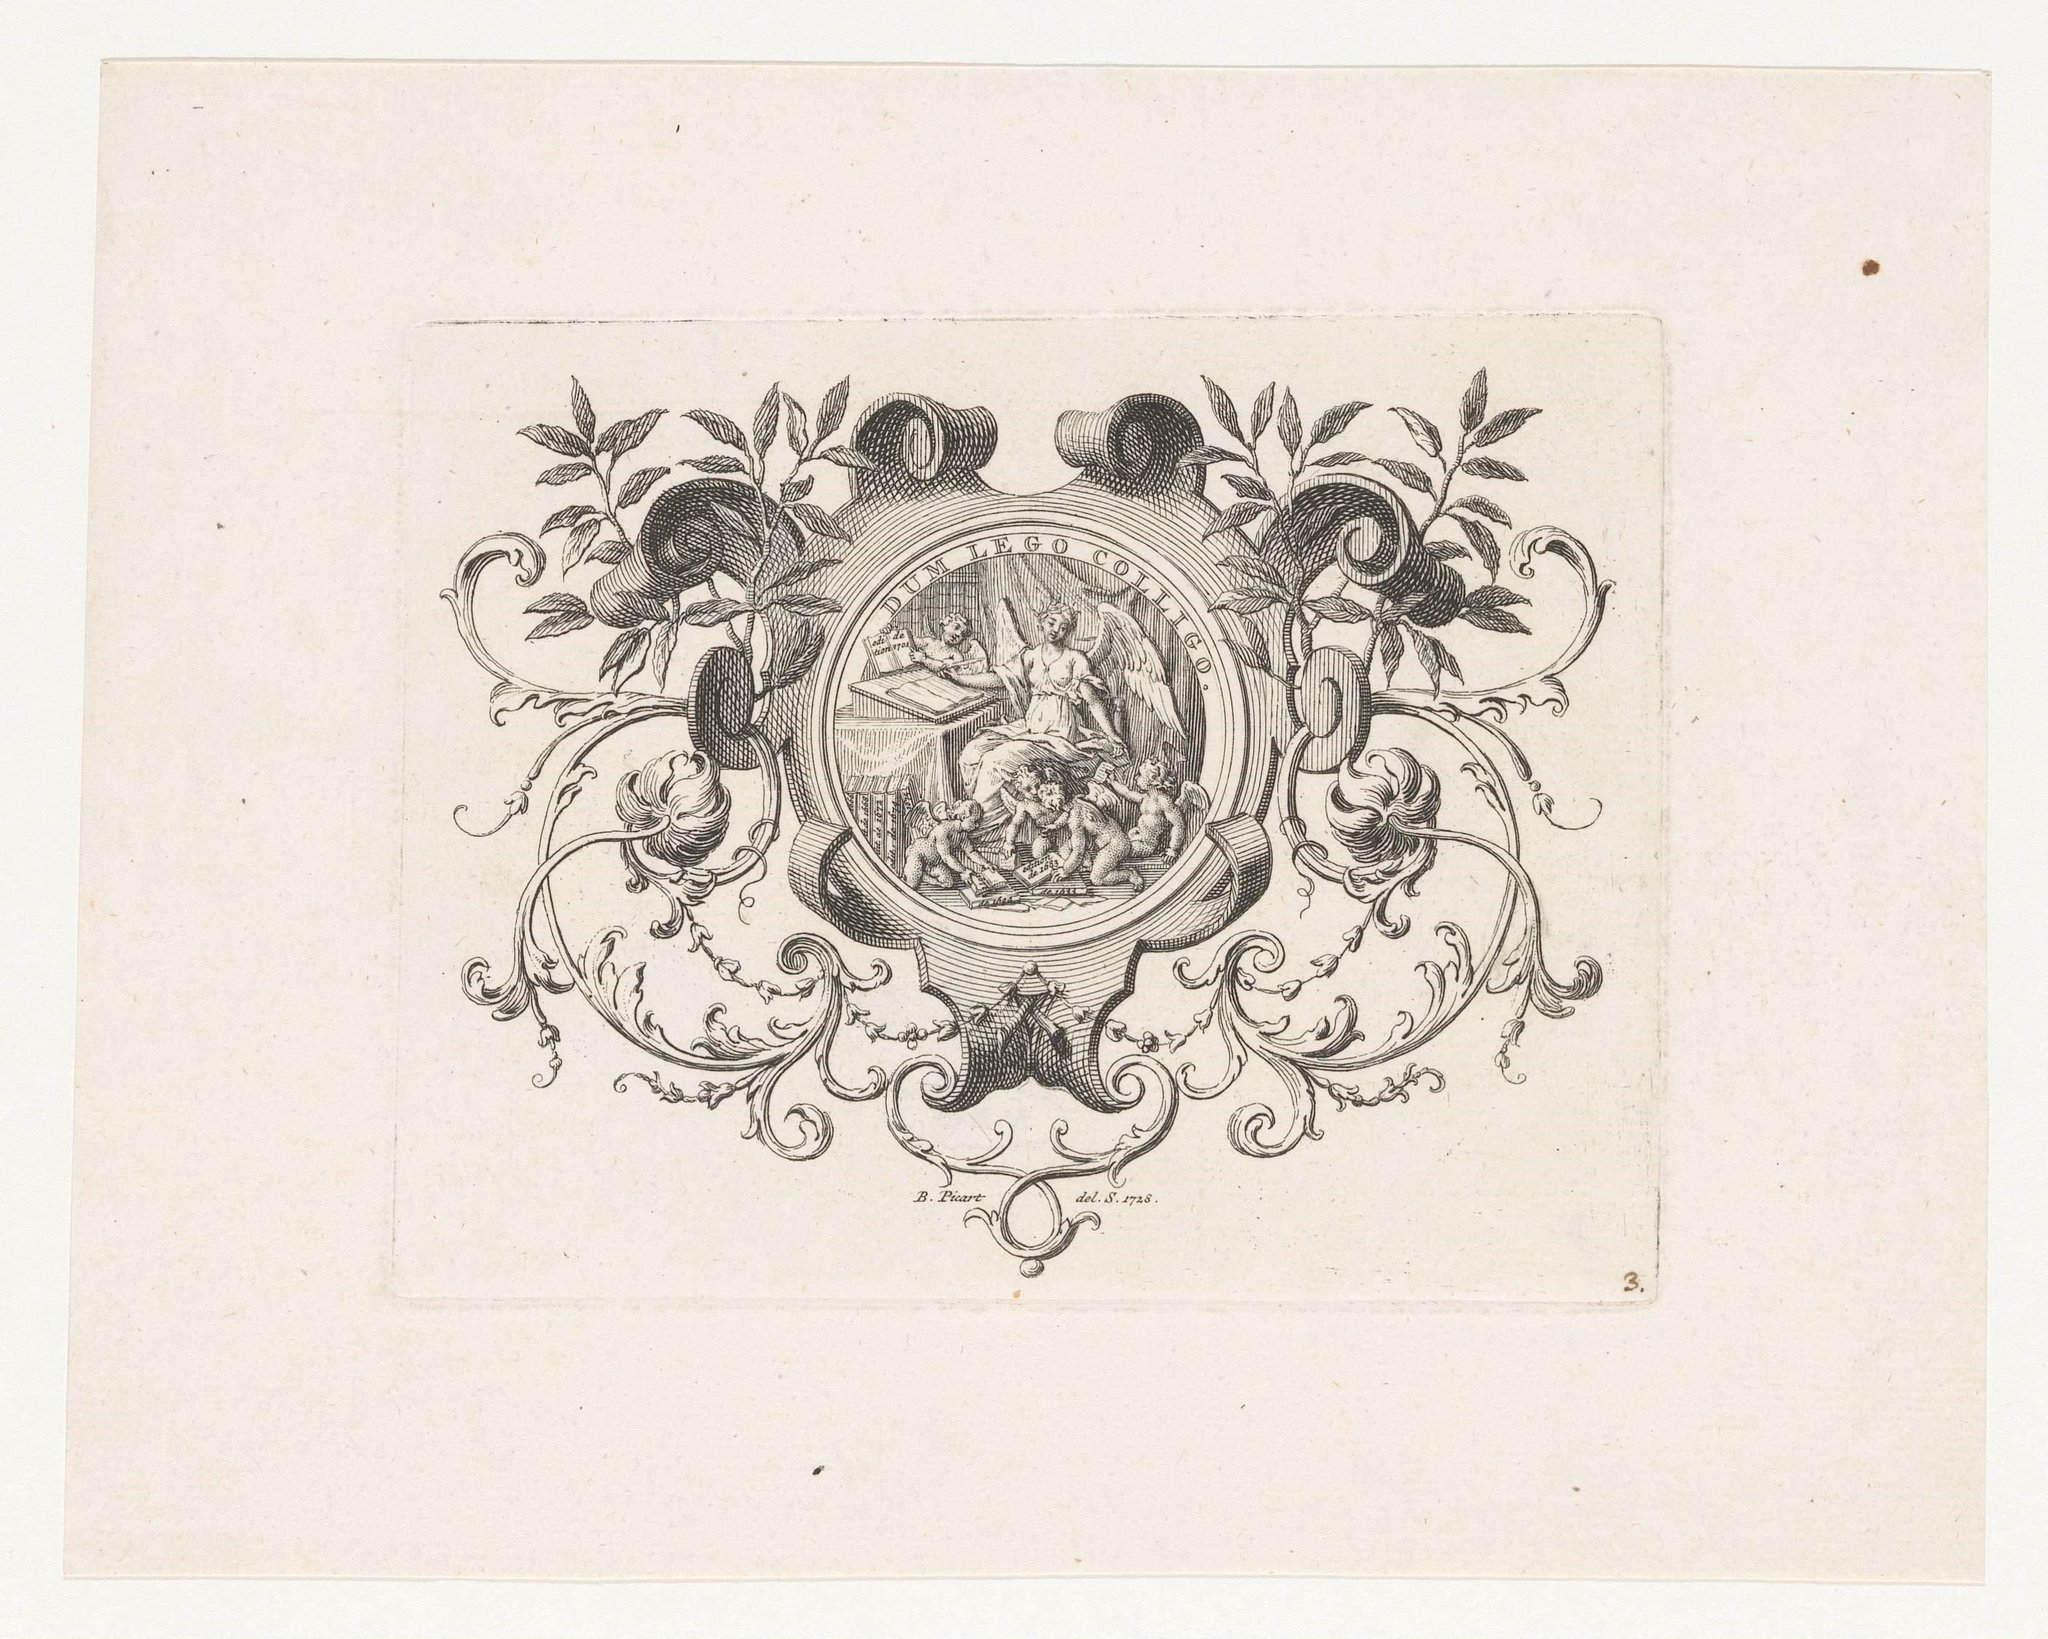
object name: print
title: Medaillon met de personificatie van Geschiedenis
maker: bernard picart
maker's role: draughtsman, print maker, publisher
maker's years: 1673-1733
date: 1728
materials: paper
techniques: engraving, etching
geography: amsterdam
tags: ornaments ~ art, book, 'historia'; 'historia' (ripa)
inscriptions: collector's mark: Lugt 2228, inscription: ‘[A]P 314’, number: ‘3.’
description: Prent mogelijk gebruikt in: Boileau-Despréaux, Nicolas. Oeuvres. Amsterdam: François Changuion, Den Haag, Pieter de Hondt, 1729. Nummer 3 in: Explication des Vignettes de la Seconde Edition des Oeuvres de Boileau. Amsterdam: Bernard Picart, 1729.